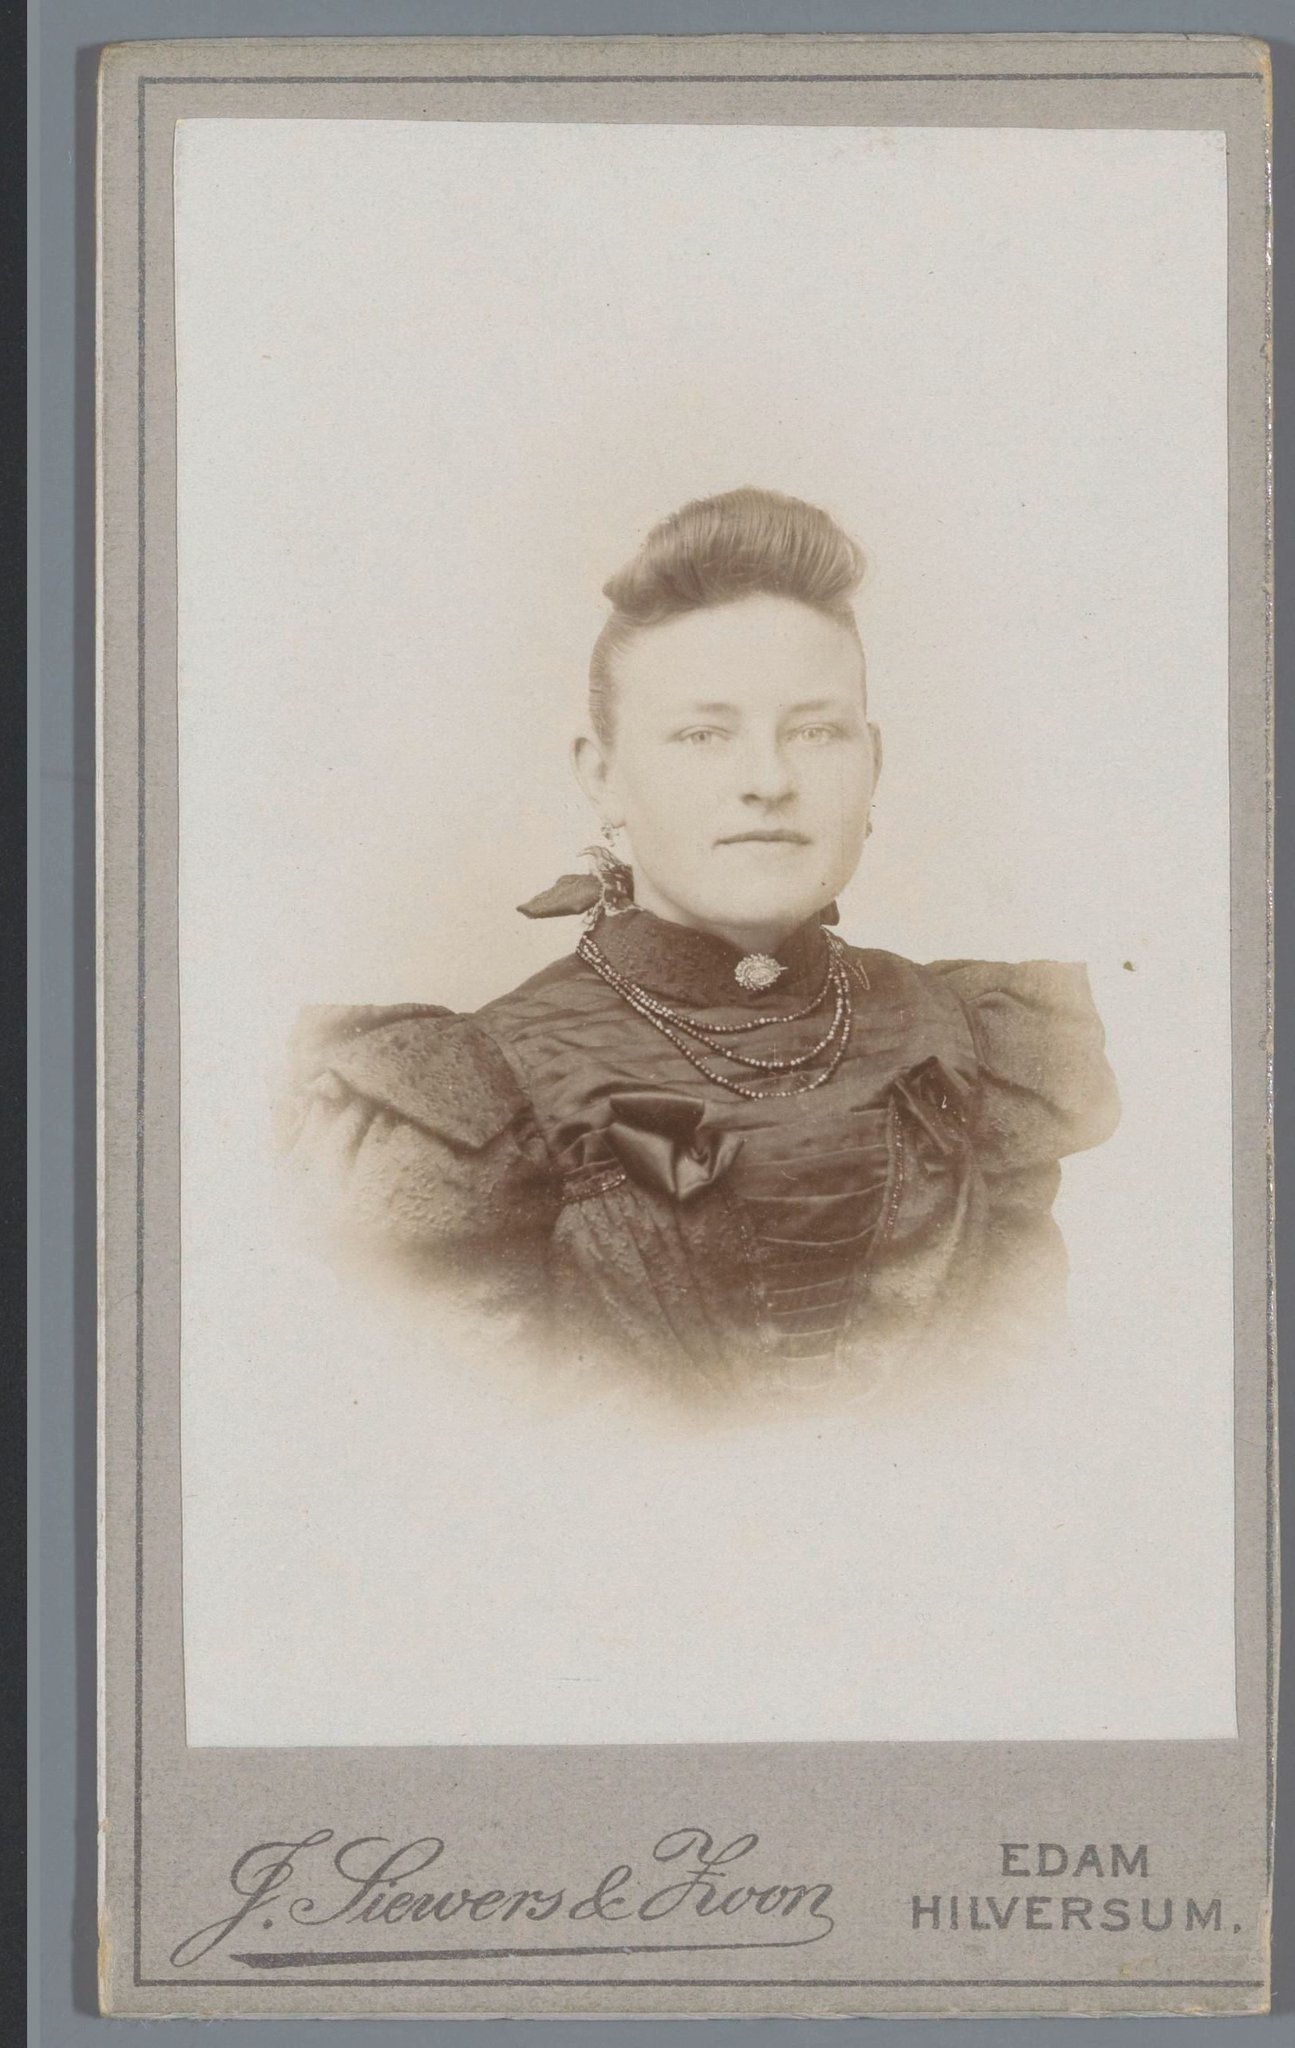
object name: photograph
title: Portret van Betje Kuyn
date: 1890-1918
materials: cardboard, photographic support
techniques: gelatin silver print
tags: historical persons - bb - woman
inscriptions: inscription: ‘Photographische/ ATELIER/ J. Siewers & Zoon/ EDAM/ HILVERSUM./ Specialiteit in vergrootingen.’, inscription: ‘Betje Kuyn’